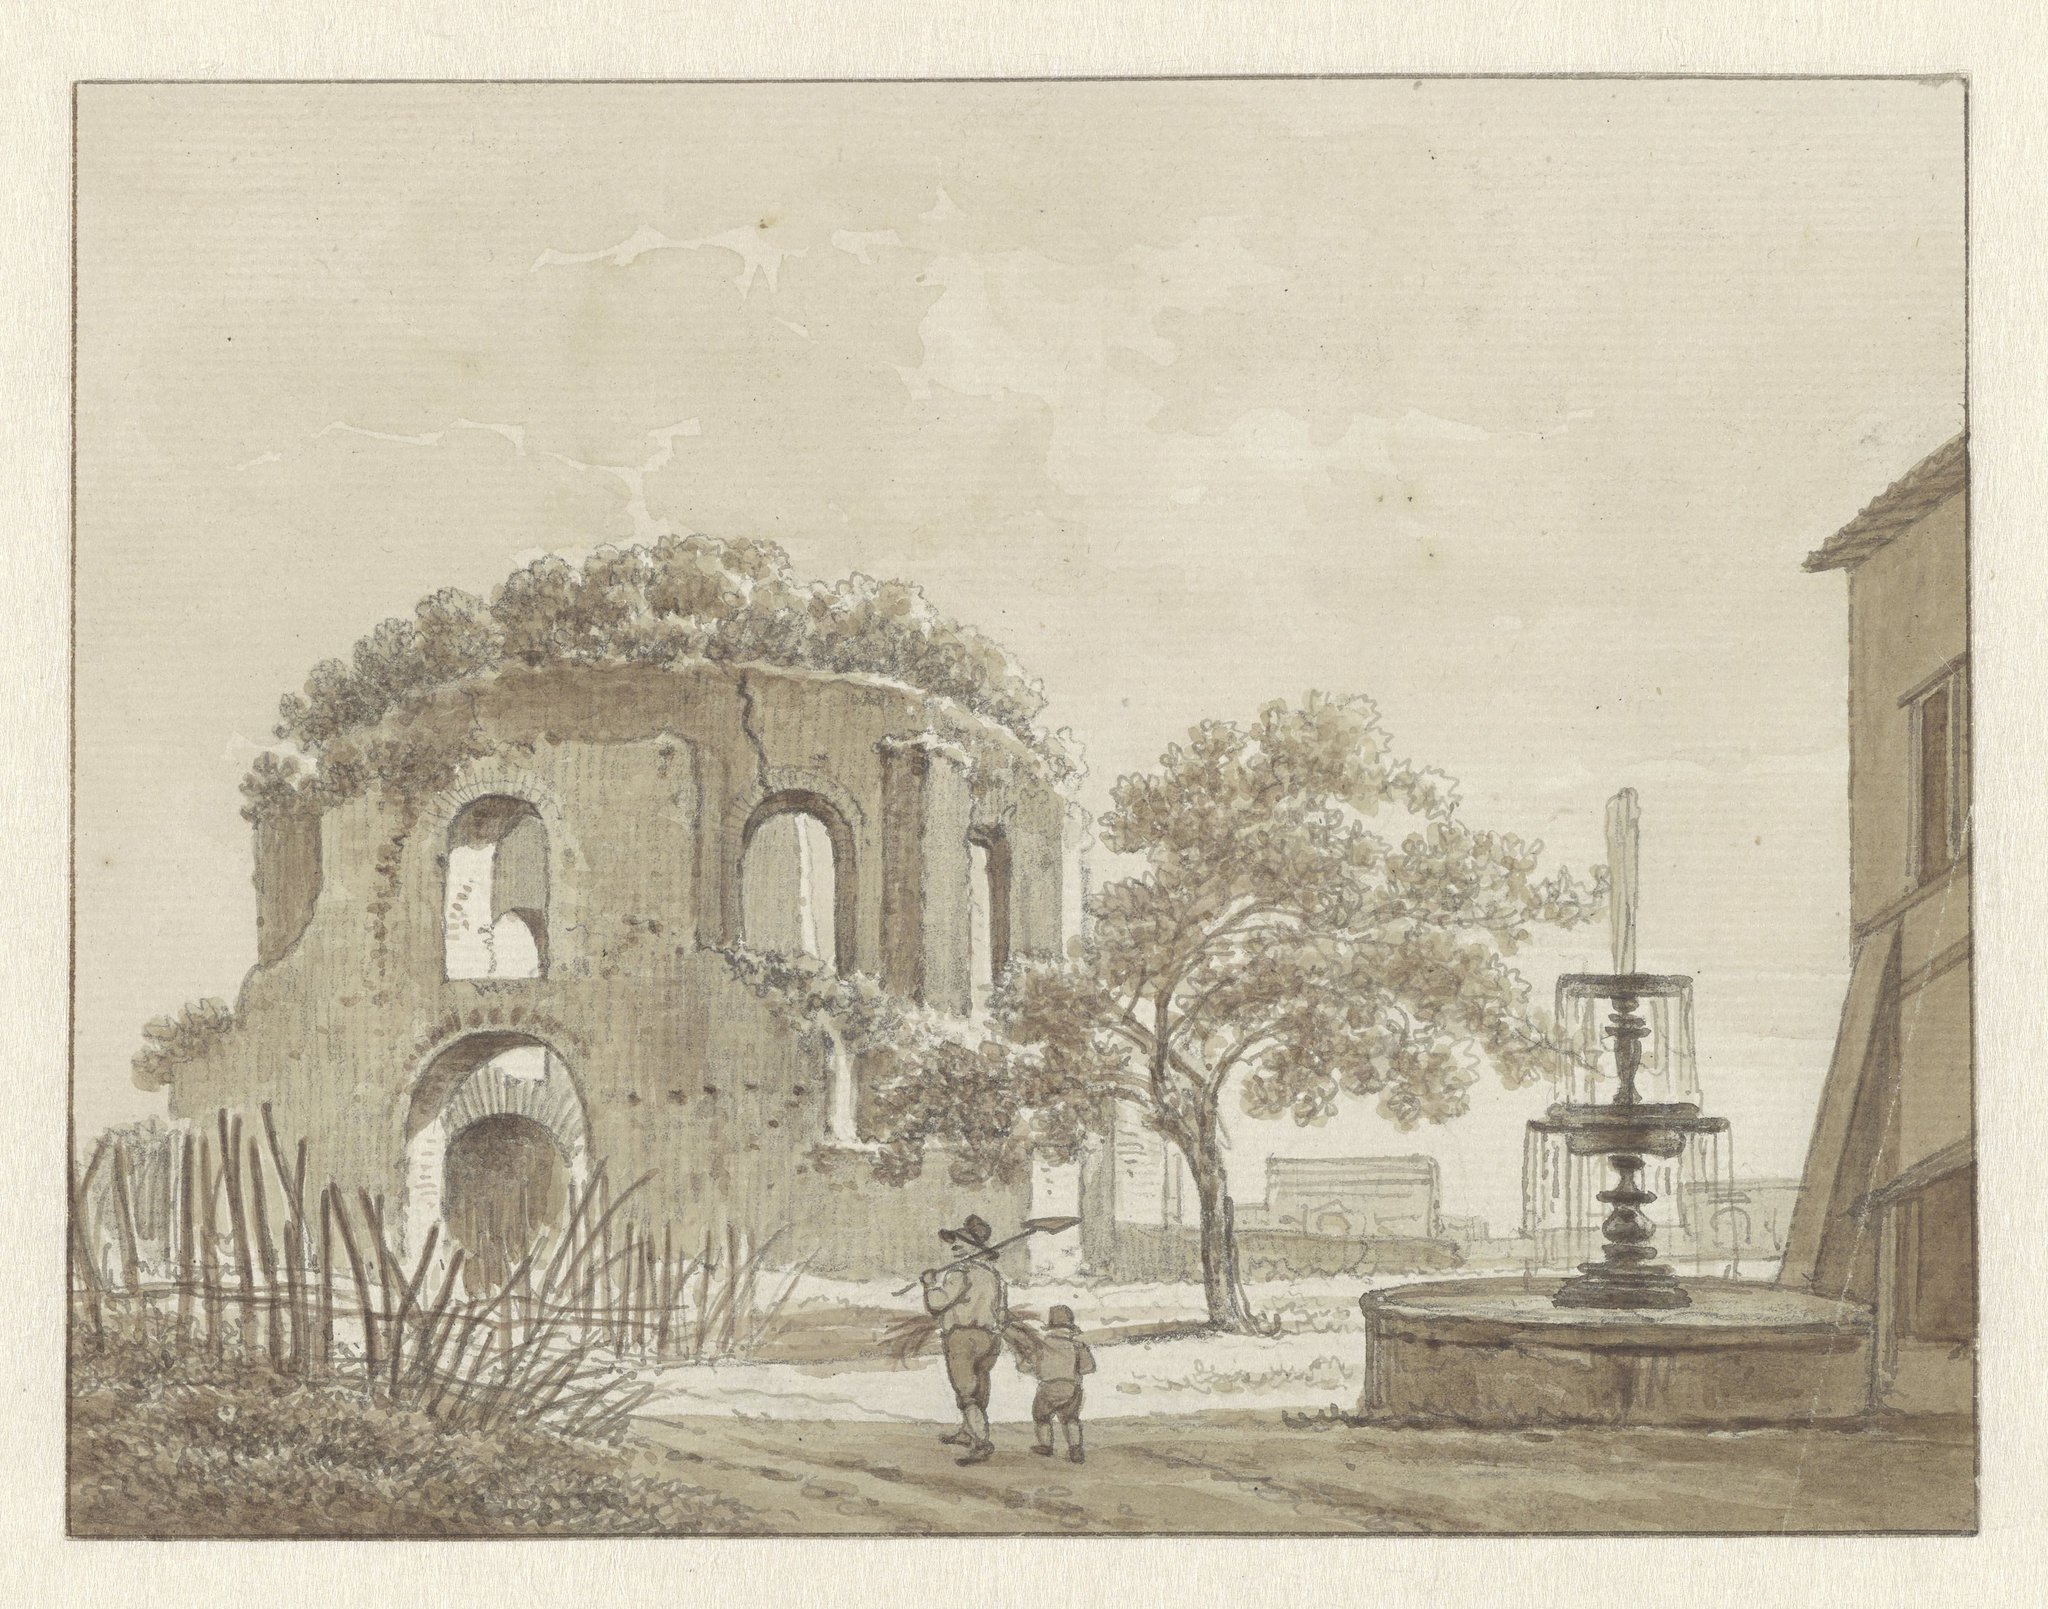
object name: drawing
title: De Tempel van Minerva Medica in Rome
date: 1761-1817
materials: graphite, ink, paper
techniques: brush, pen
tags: landscape with ruins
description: Tekening uit een groep tekeningen van landschappen en stadsgezichten in Italië (Rome, Tivoli, Civita Castellana en Pozzuoli).